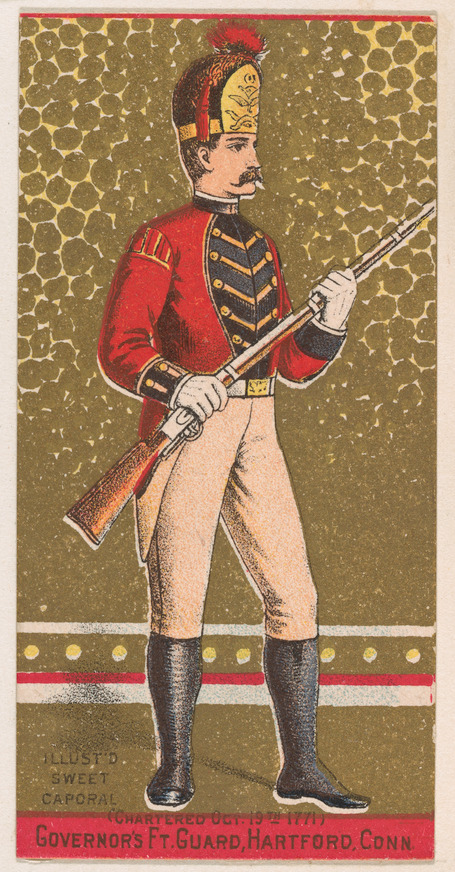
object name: print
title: Governor's Foot Guard, Hartford, Connecticut, from the Military Series (N224) issued by Kinney Tobacco Company to promote Sweet Caporal Cigarettes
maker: kinney brothers tobacco company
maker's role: publisher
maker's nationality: american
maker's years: 1869-2011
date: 1888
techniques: color lithograph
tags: military,men